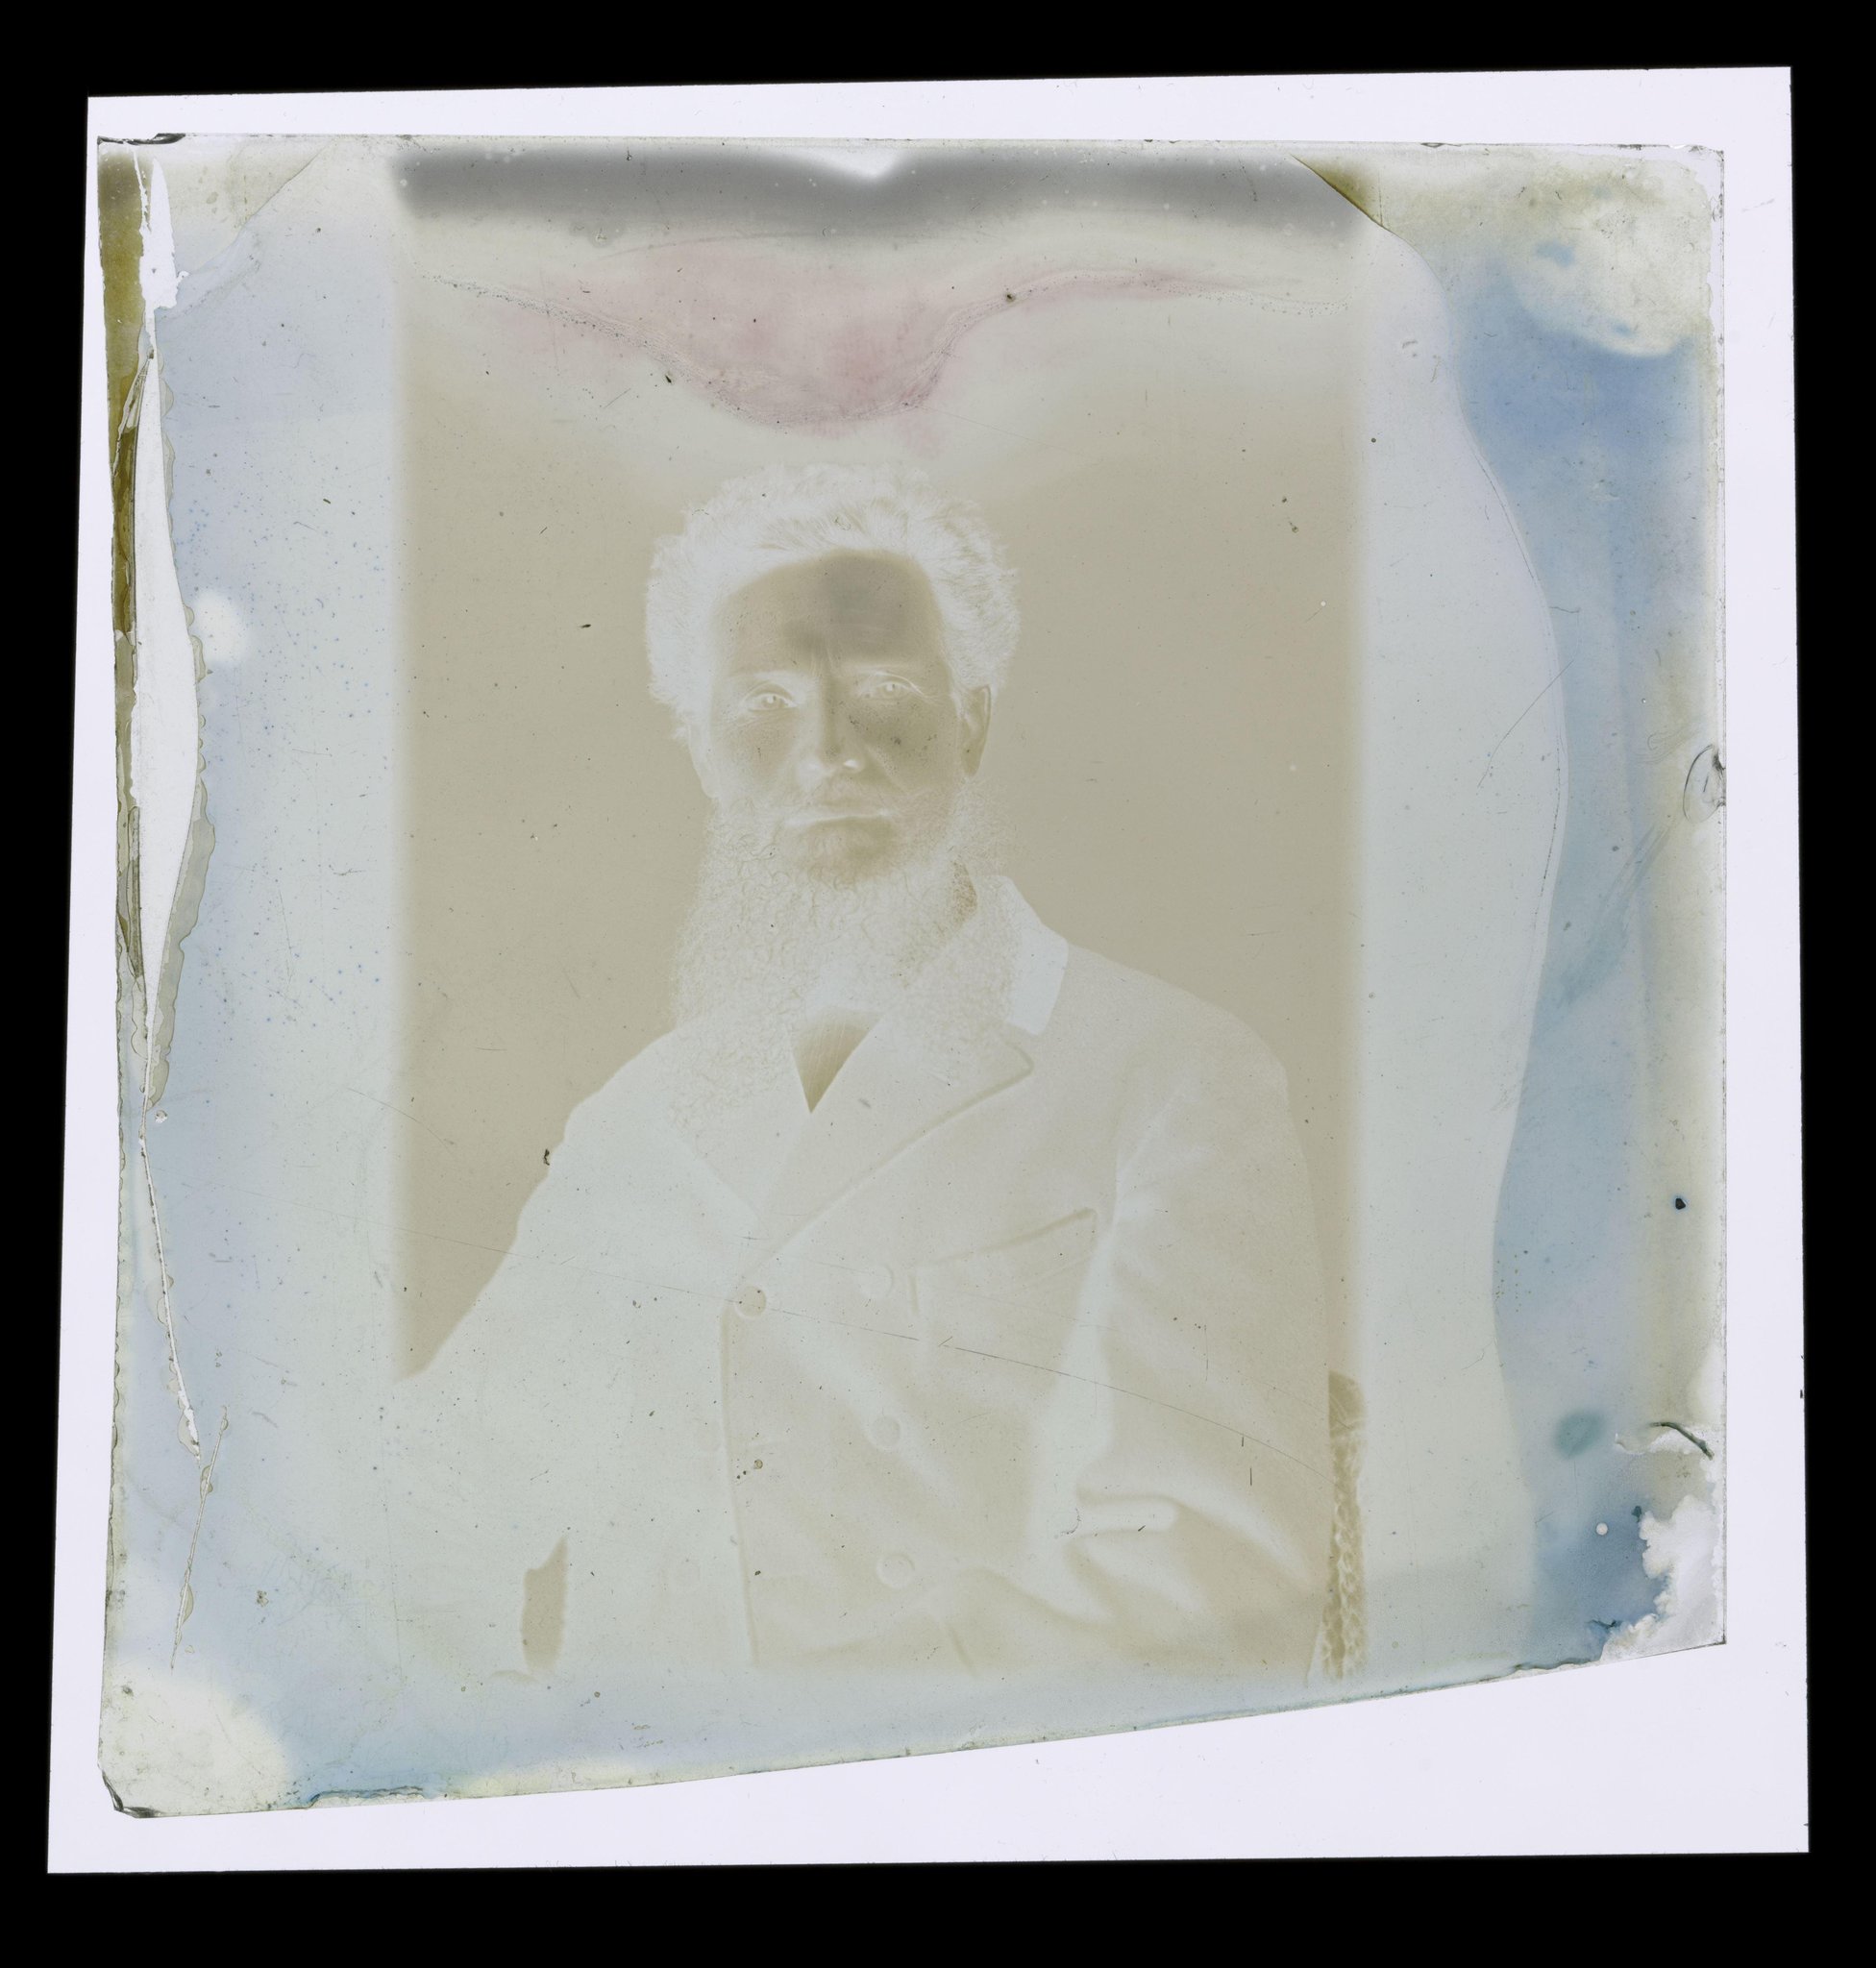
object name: glasnegatief, glasplaatnegatief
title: Zelfportret van Laurens Lodewijk Kleijn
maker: laurens lodewijk kleijn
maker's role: draughtsman, painter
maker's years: 1826-1909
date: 1865-1900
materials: glass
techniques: collodion process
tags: painter, draughtsman, laurens lodewijk kleijn, historical persons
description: Onderdeel van een groep glasnegatieven uit de nalatenschap van de schilder Laurens Lodewijk Kleijn, met stillevens, portretten, zelfportretten en kunstreproducties.